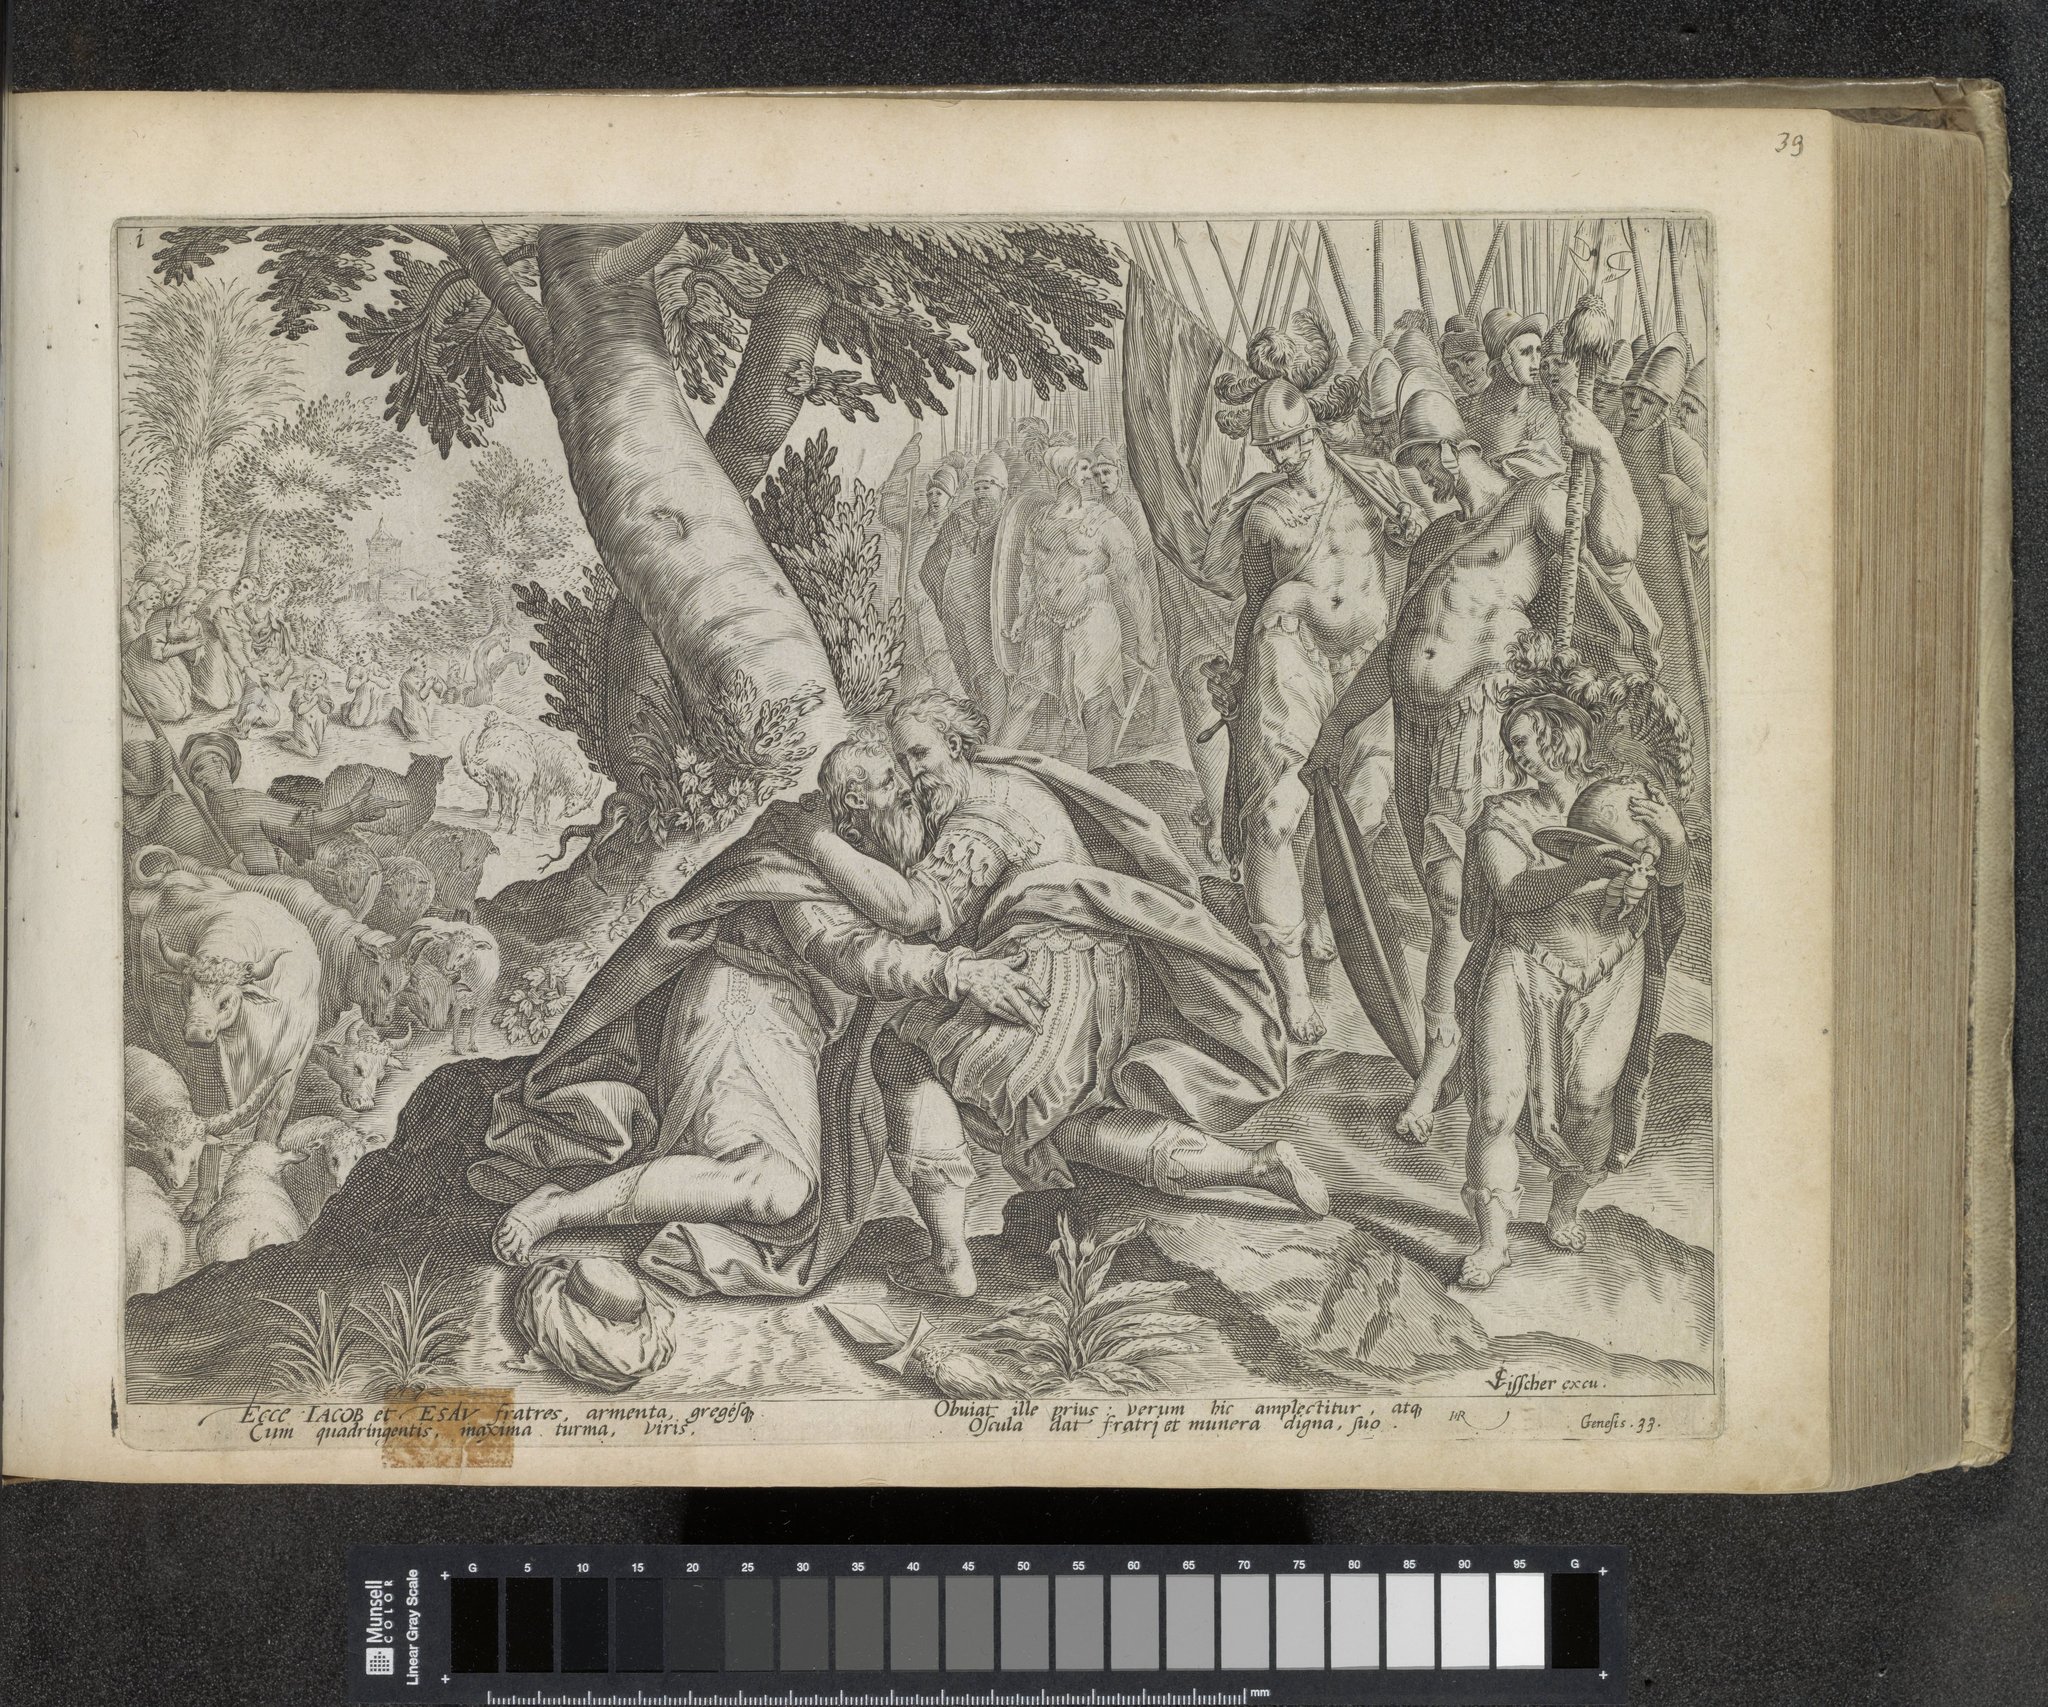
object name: album leaf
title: Theatrum Biblicum Hoc Est Historiae Sacrae Veteris et Novi Testamenti Tabulis Aeneis Expressae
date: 1643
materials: paper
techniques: engraving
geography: amsterdam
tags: the meeting between esau and jacob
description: Esau en Jakob omhelzen elkaar. Rechts, achter Esau staat zijn leger. Links het vee en de geknielde vrouwen en kinderen van Jakob. Onder de voorstelling twee verzen in het Latijn en een verwijzing naar de Bijbeltekst in Gen. 33. Deze prent maakt deel uit van een album.